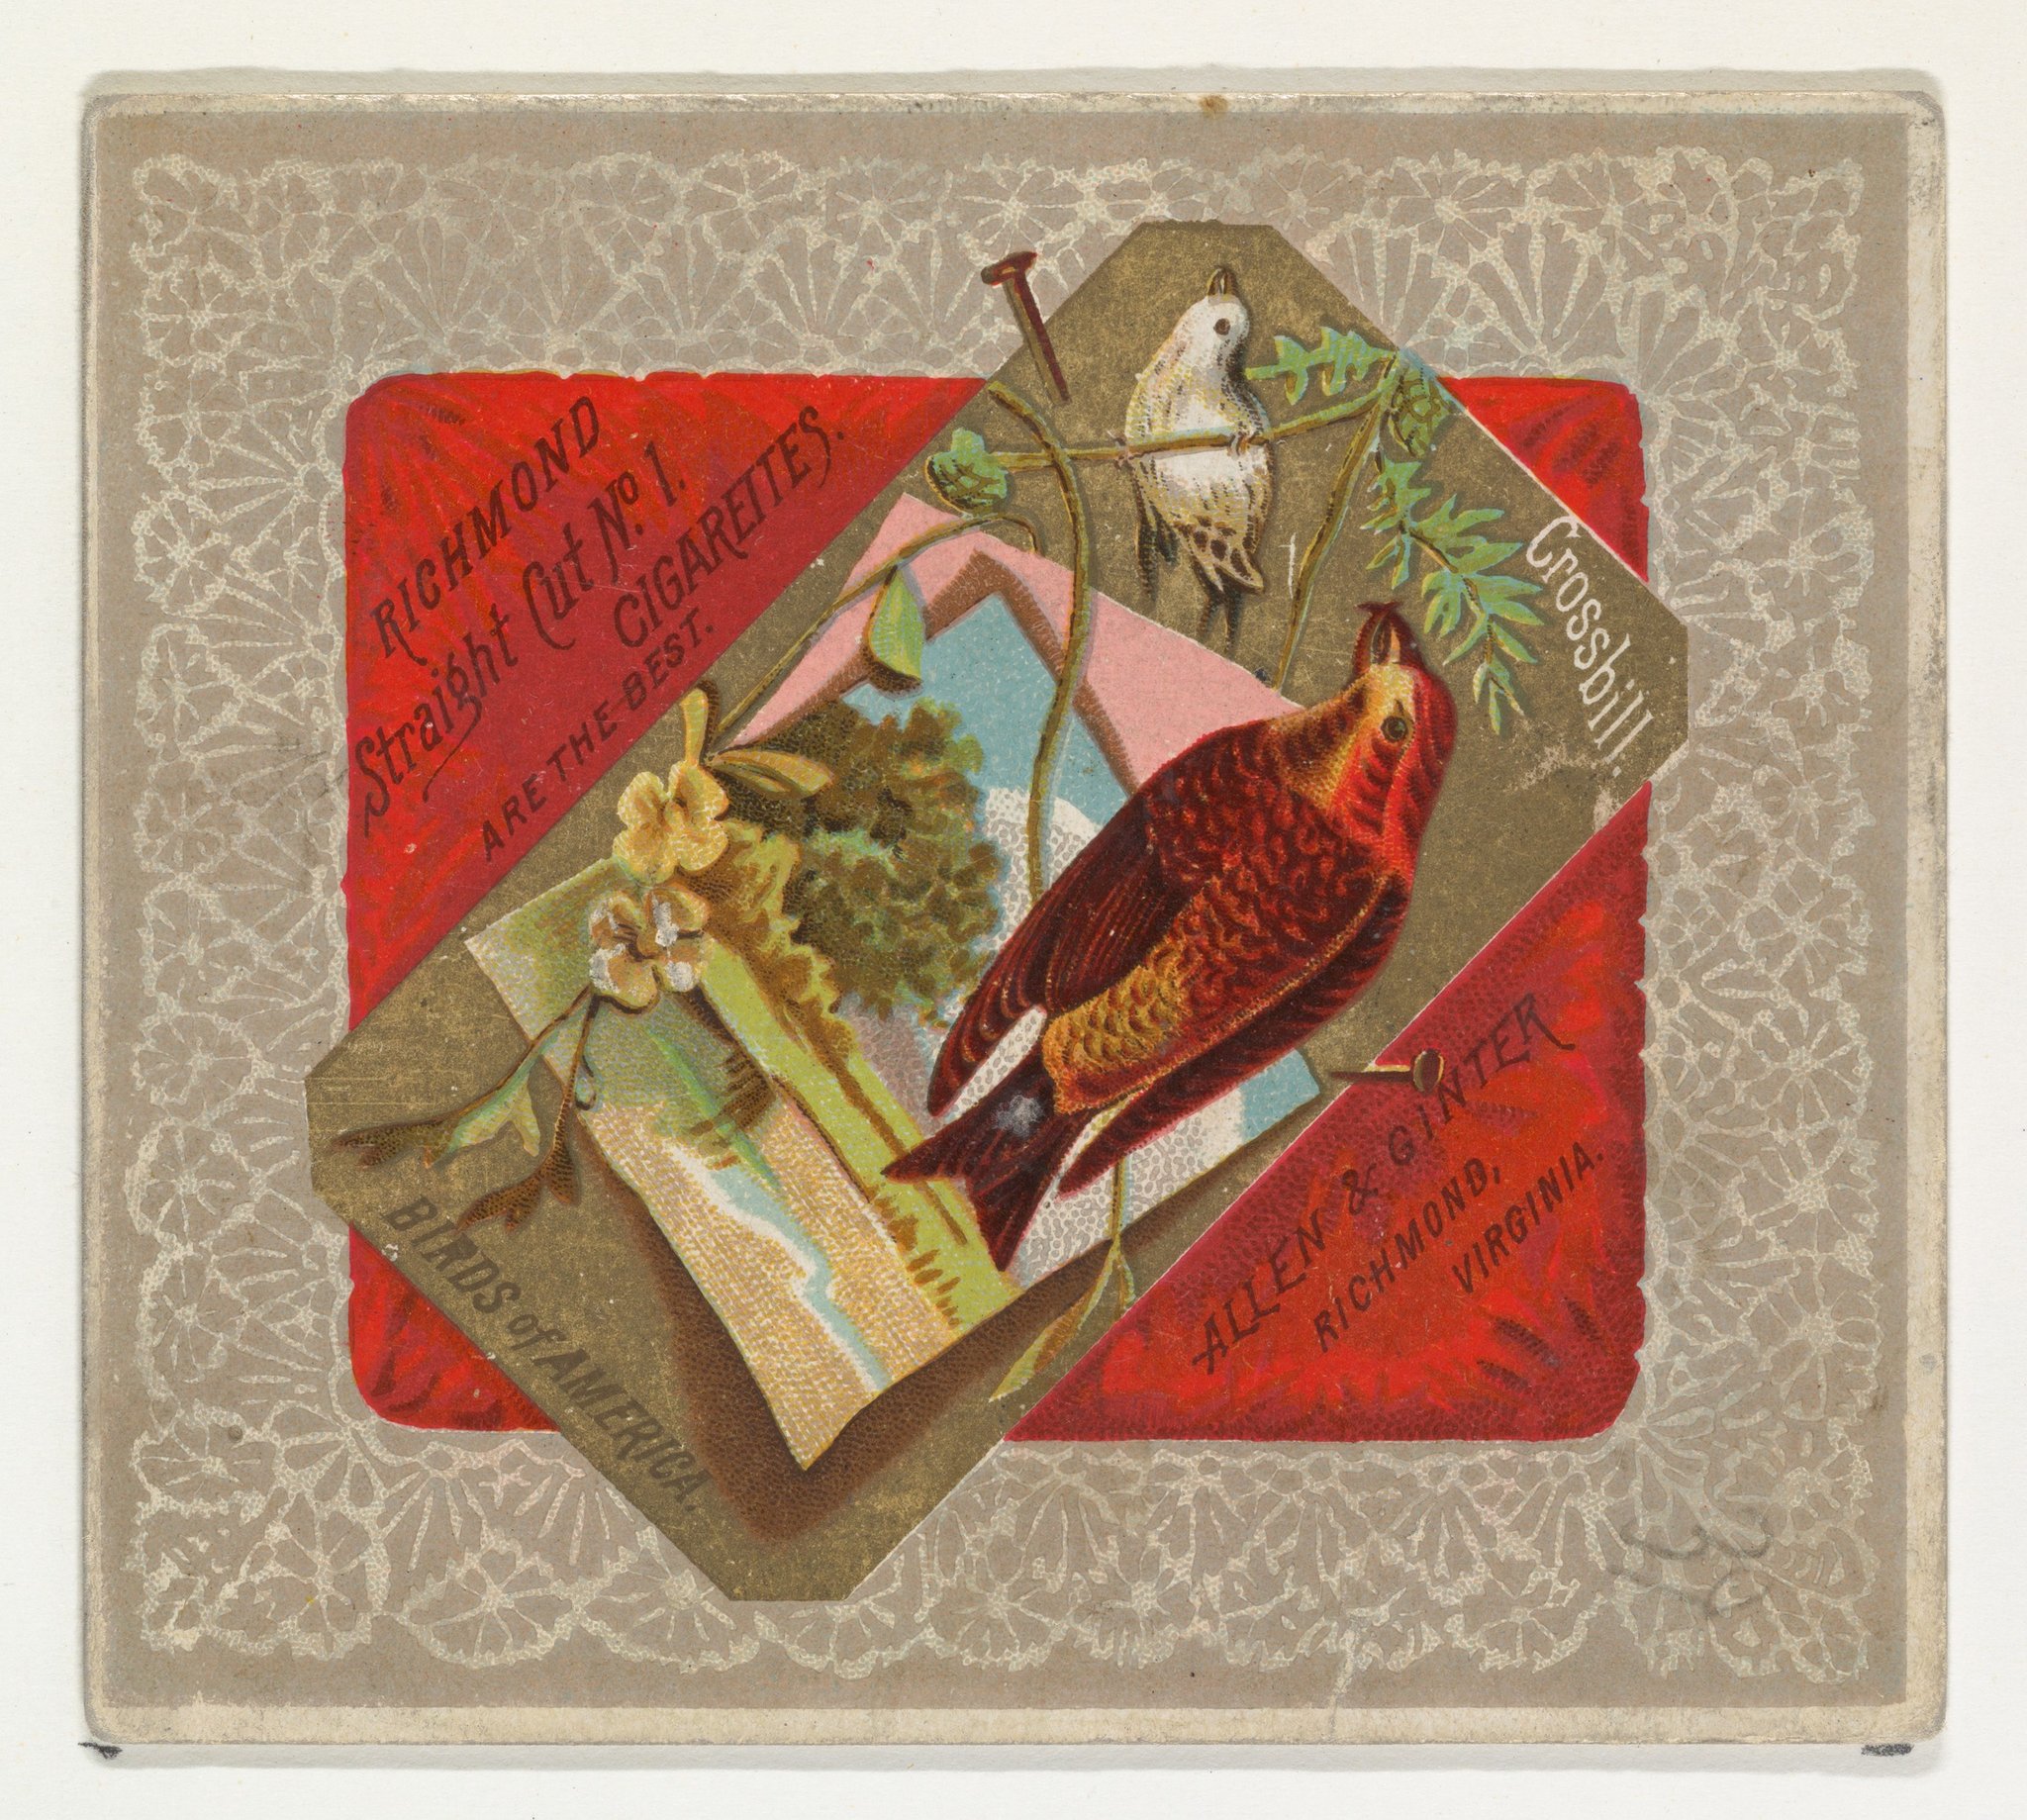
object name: print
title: Crossbill, from the Birds of America series (N37) for Allen & Ginter Cigarettes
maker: allen & ginter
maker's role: publisher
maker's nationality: american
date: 1888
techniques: color lithograph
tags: birds